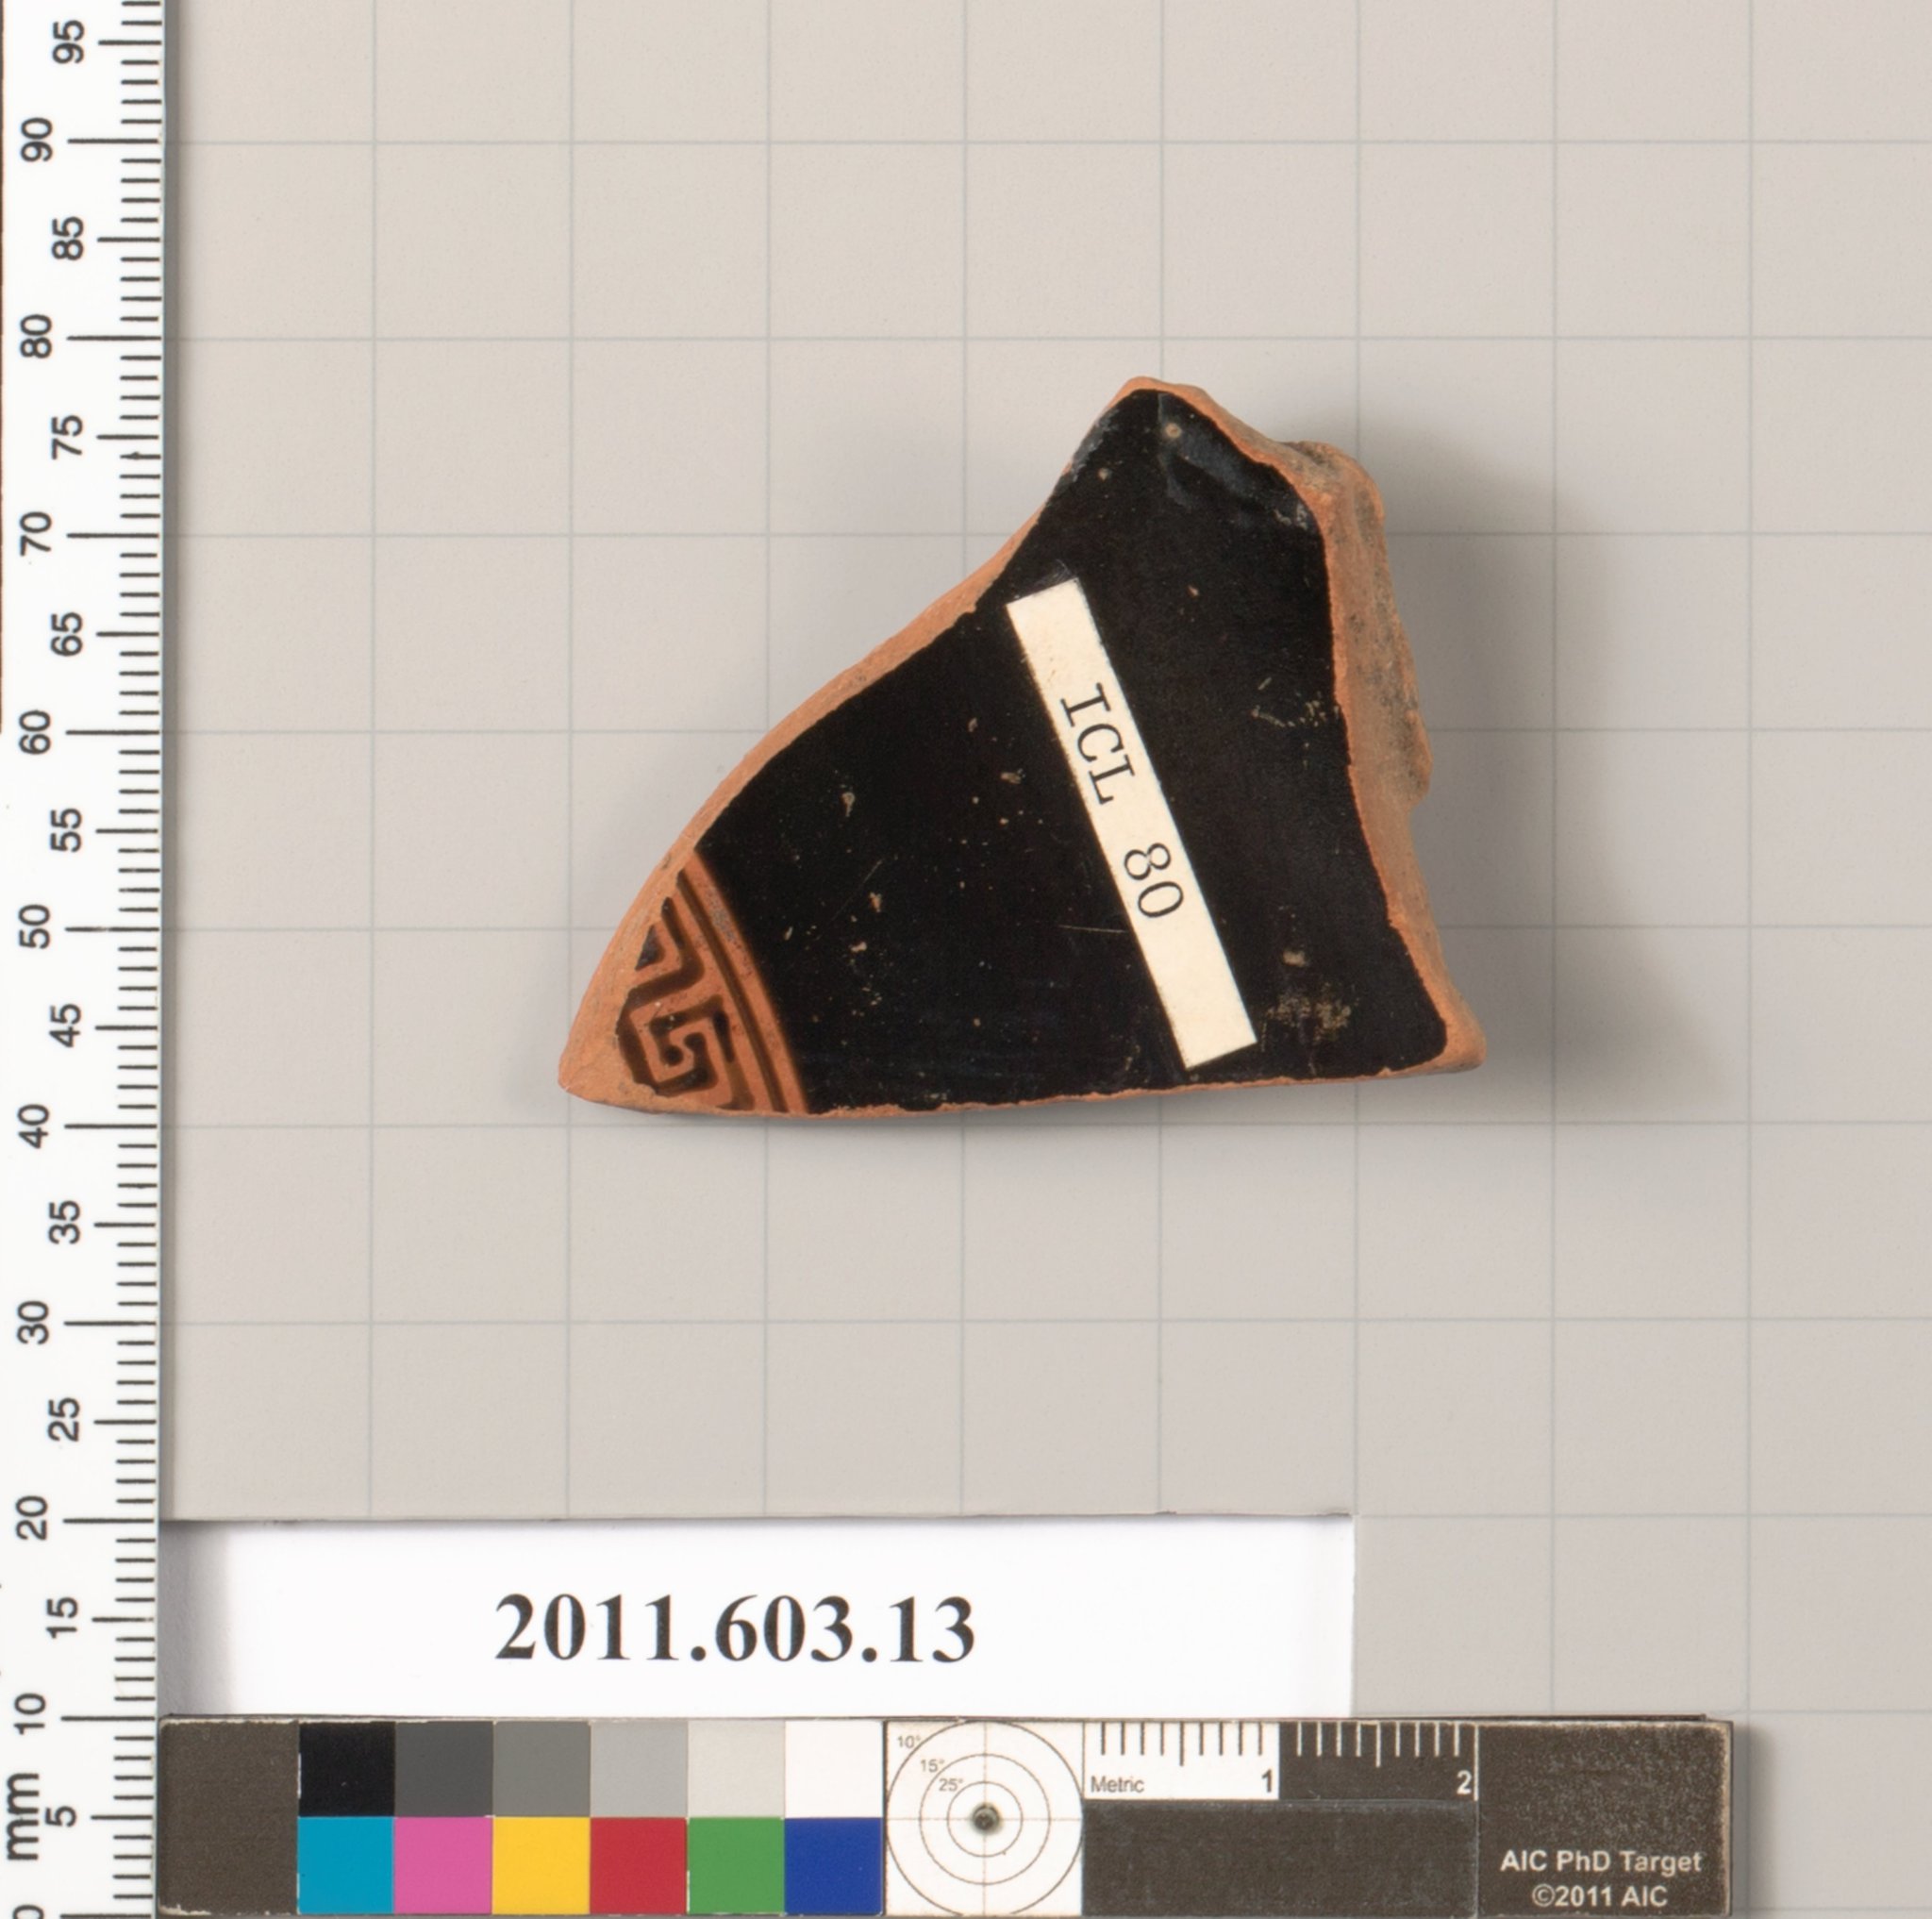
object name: kylix fragment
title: Fragment of a terracotta kylix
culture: greek, attic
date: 500-451 BCE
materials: terracotta